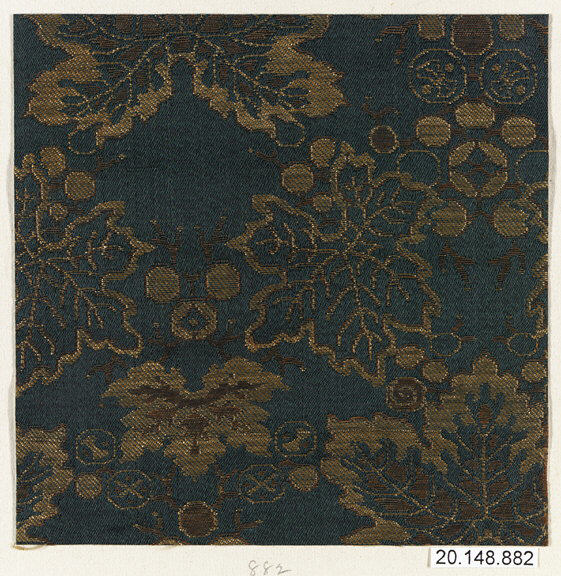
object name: piece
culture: japanese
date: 1701-1800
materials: silk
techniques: compound weave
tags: leaves